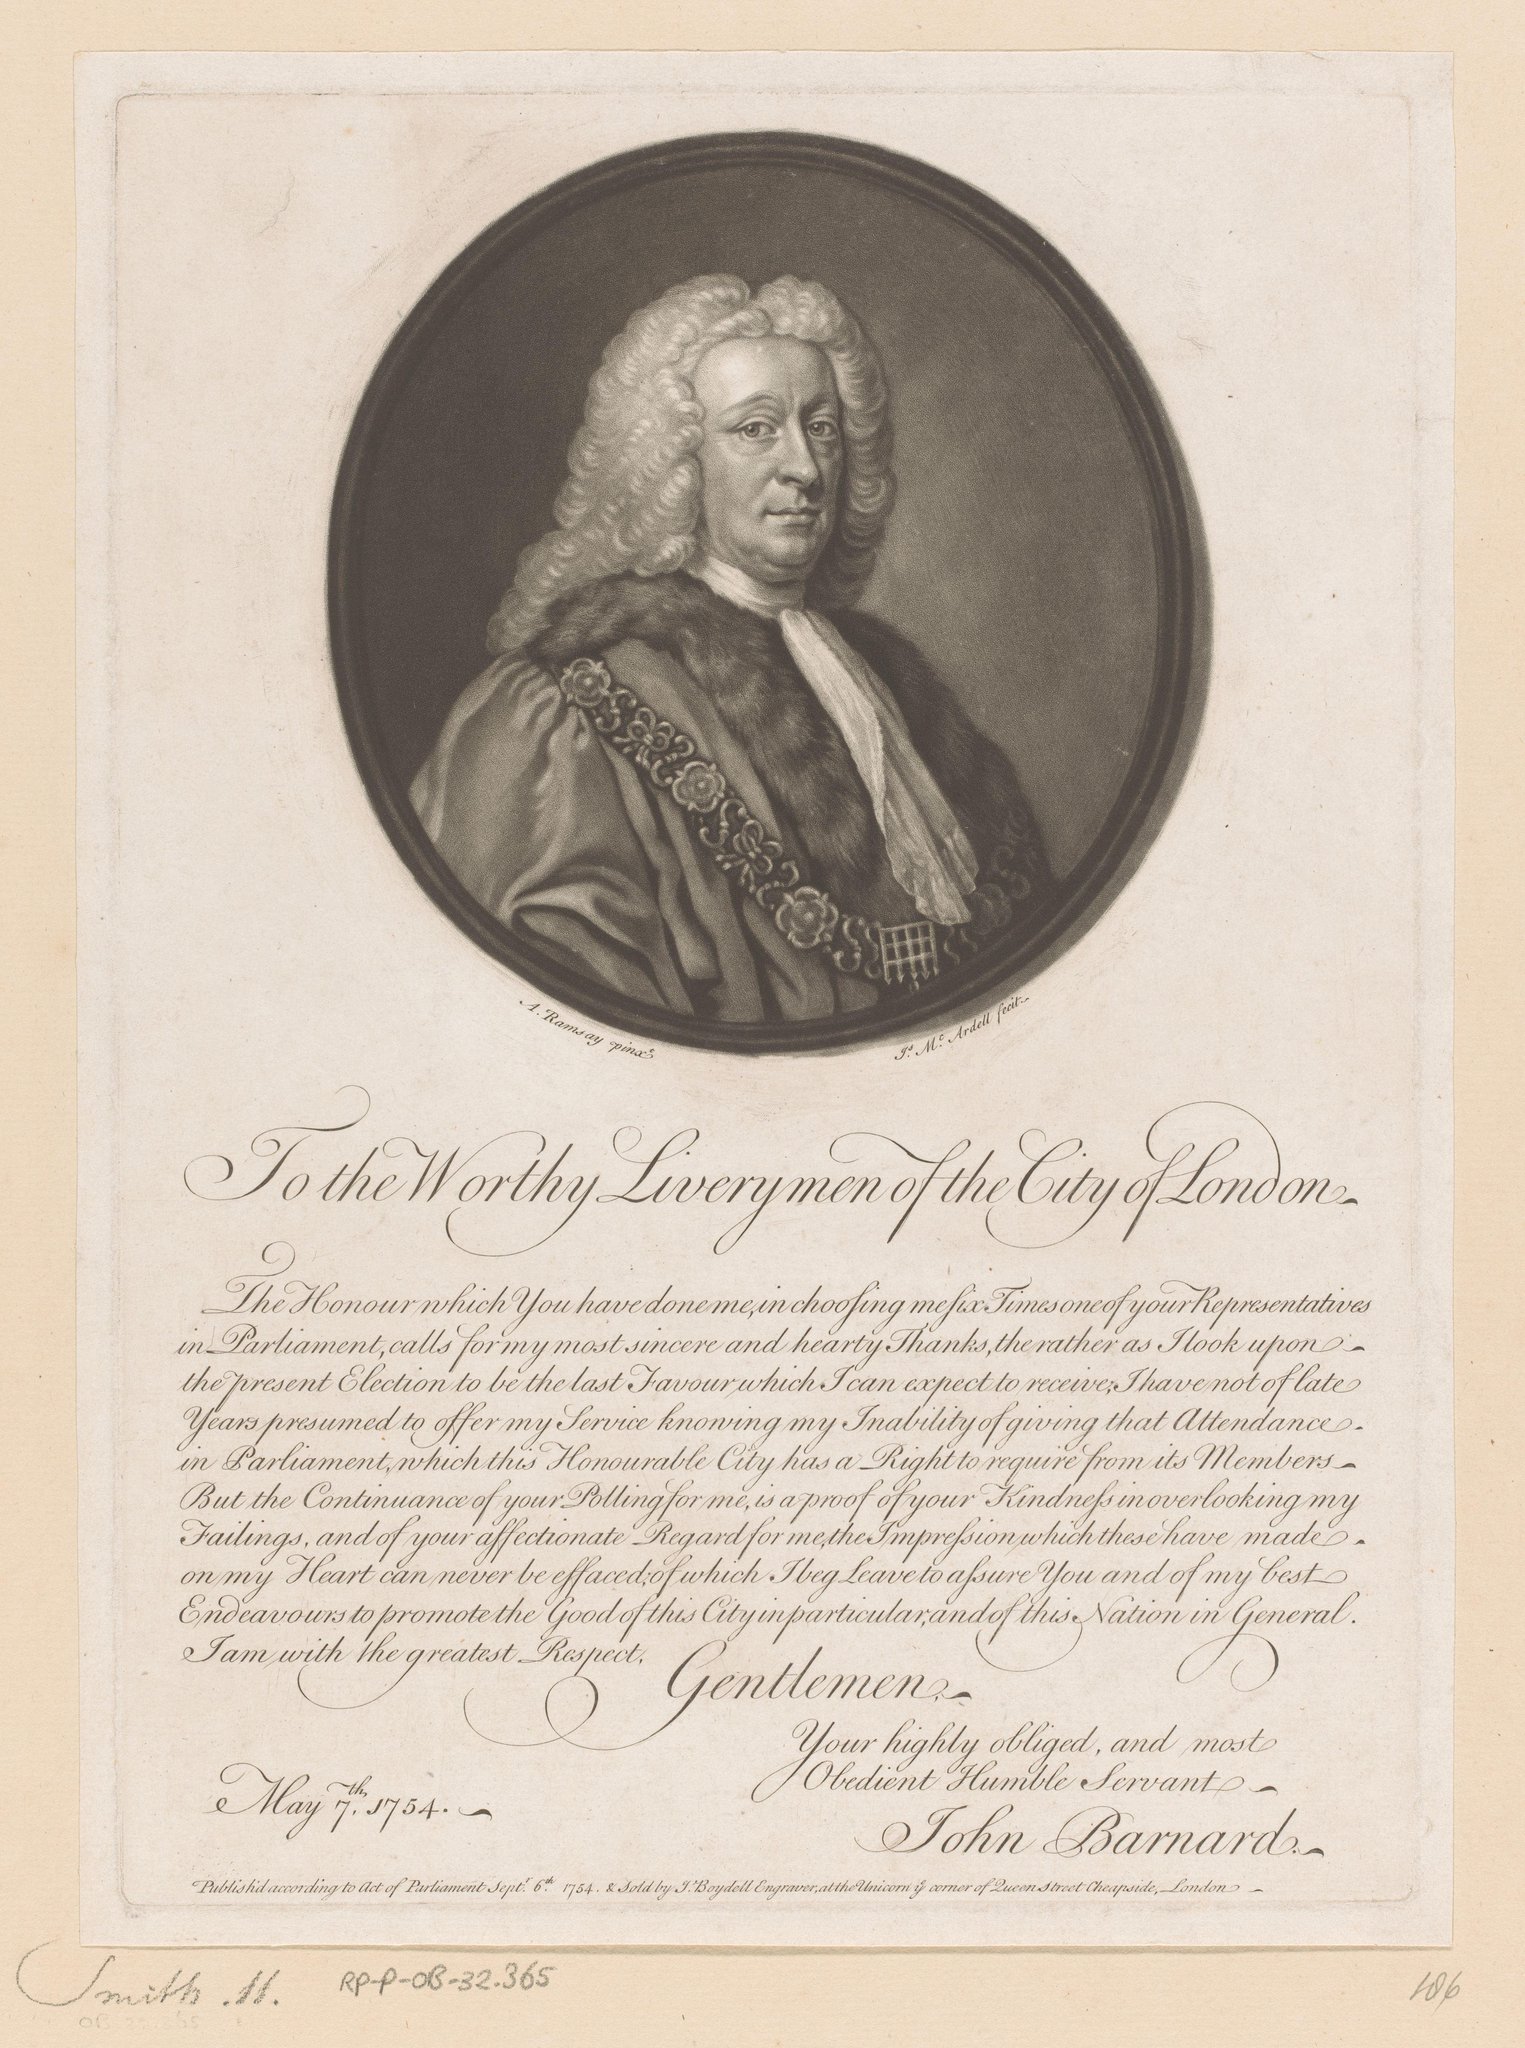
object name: print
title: Portret van John Barnard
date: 1754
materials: paper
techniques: mezzotint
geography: london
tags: politician, mayor, john barnard, mayor, burgomaster, historical persons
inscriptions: collector's mark: Lugt 240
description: Portret van Barnard als burgemeester van Londen. Met onder prent een dankwoord van John Barnard gericht aan de 'Worthy Liverymen of the City of London'. Het onderschrift werd gekopieerd van de prent van John Faber II.